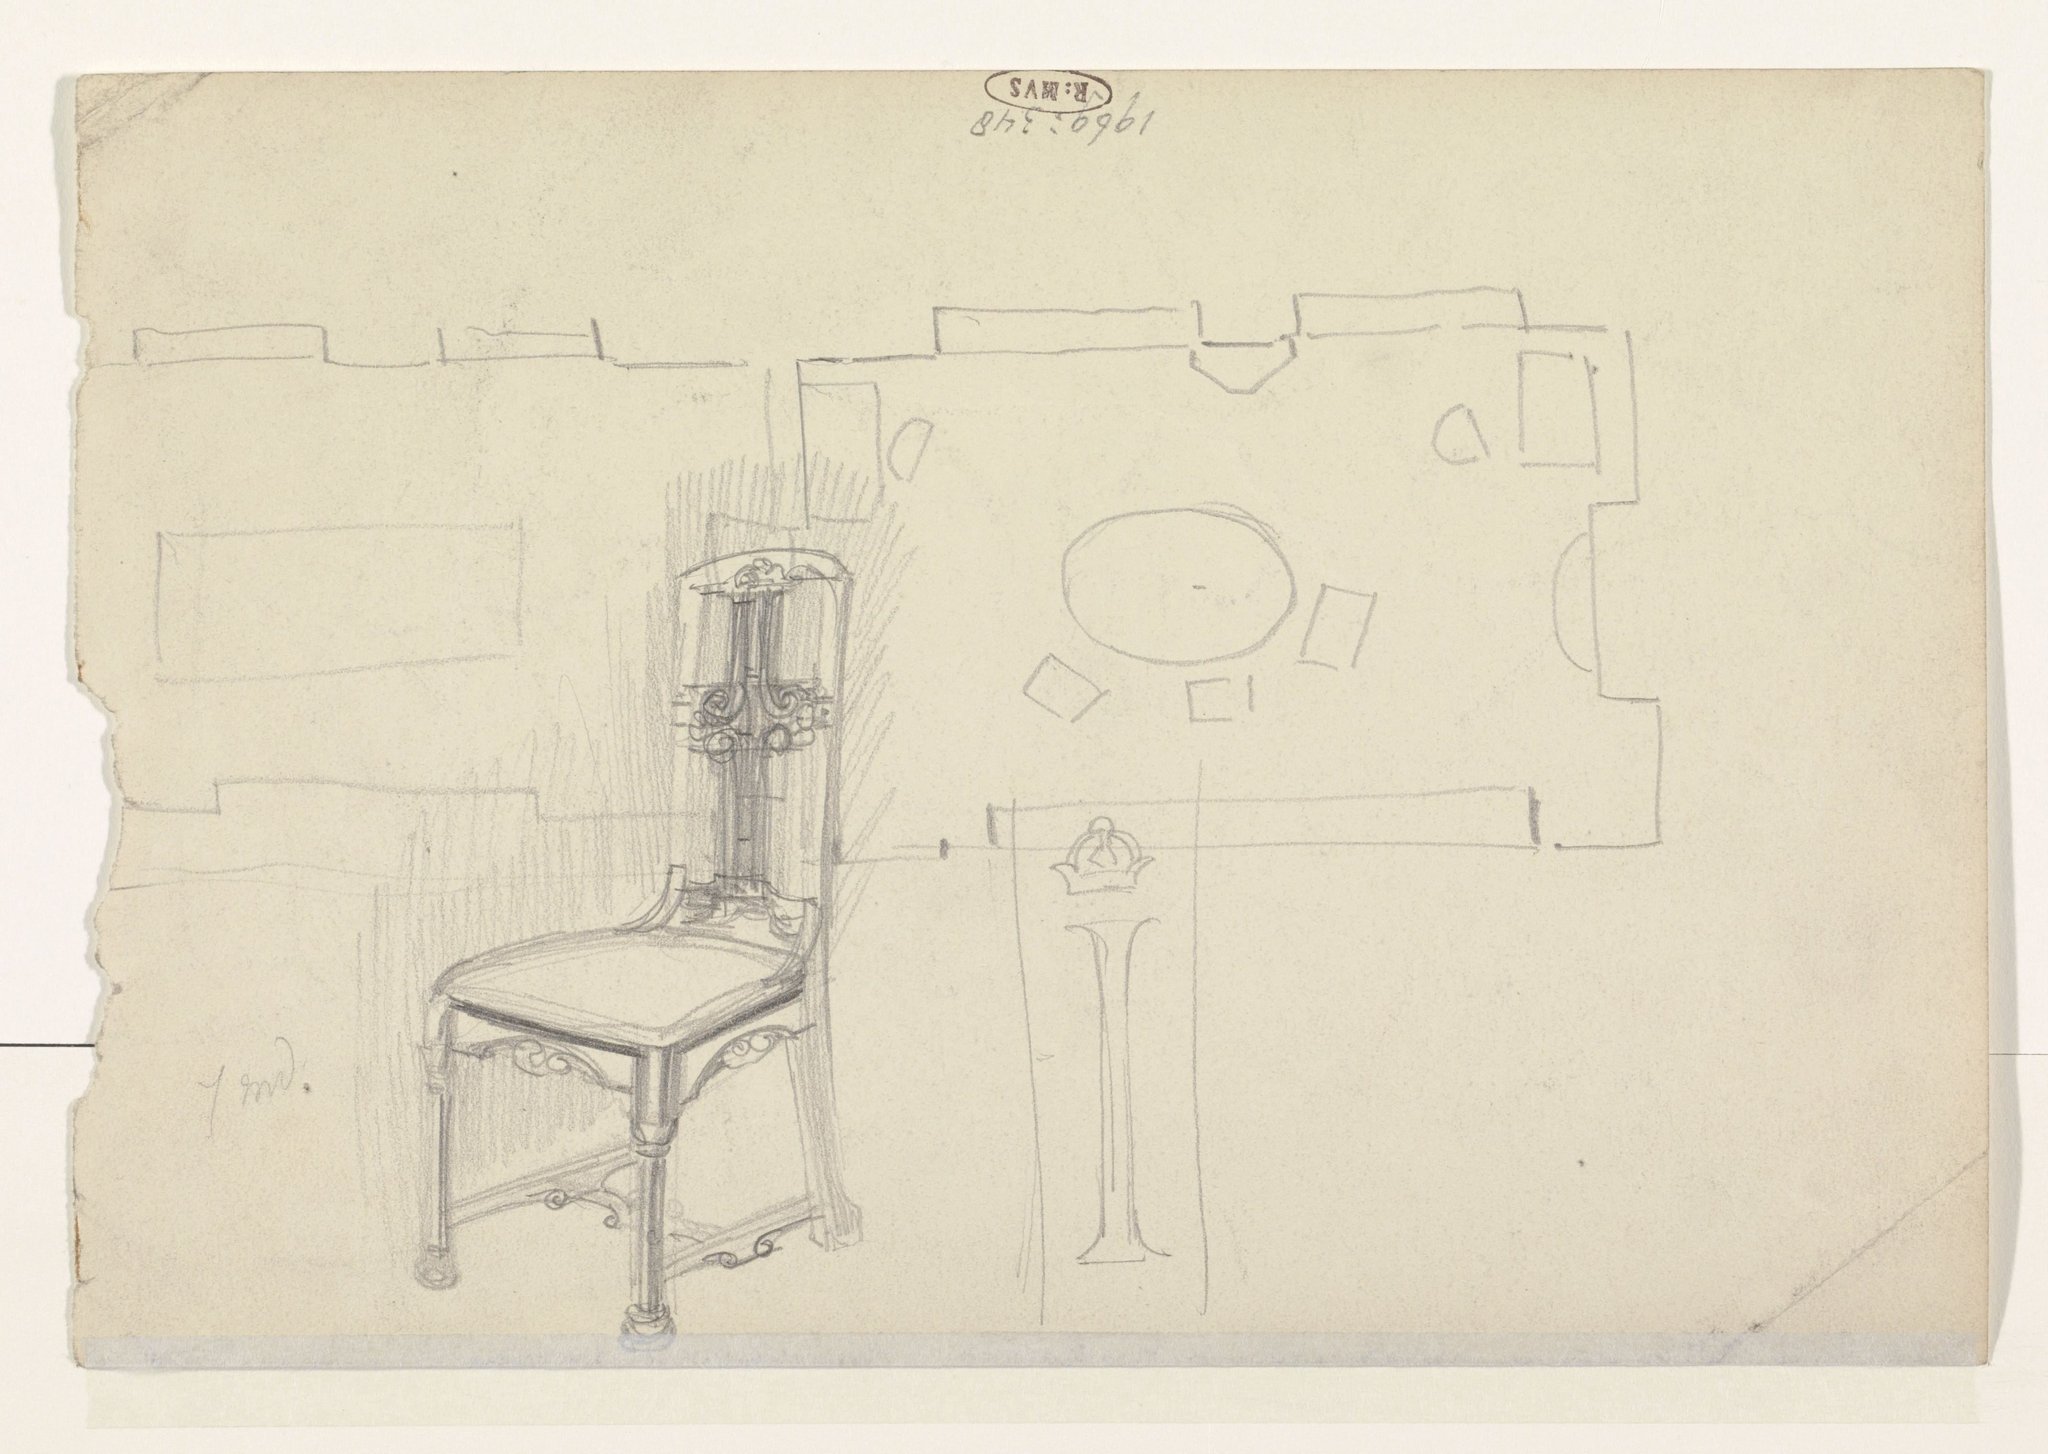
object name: drawing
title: Ontwerp voor een stoel en een plattegrond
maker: carel adolph lion cachet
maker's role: draughtsman, print maker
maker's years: 1864-1945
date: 1874-1945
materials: paper, pencil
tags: chair